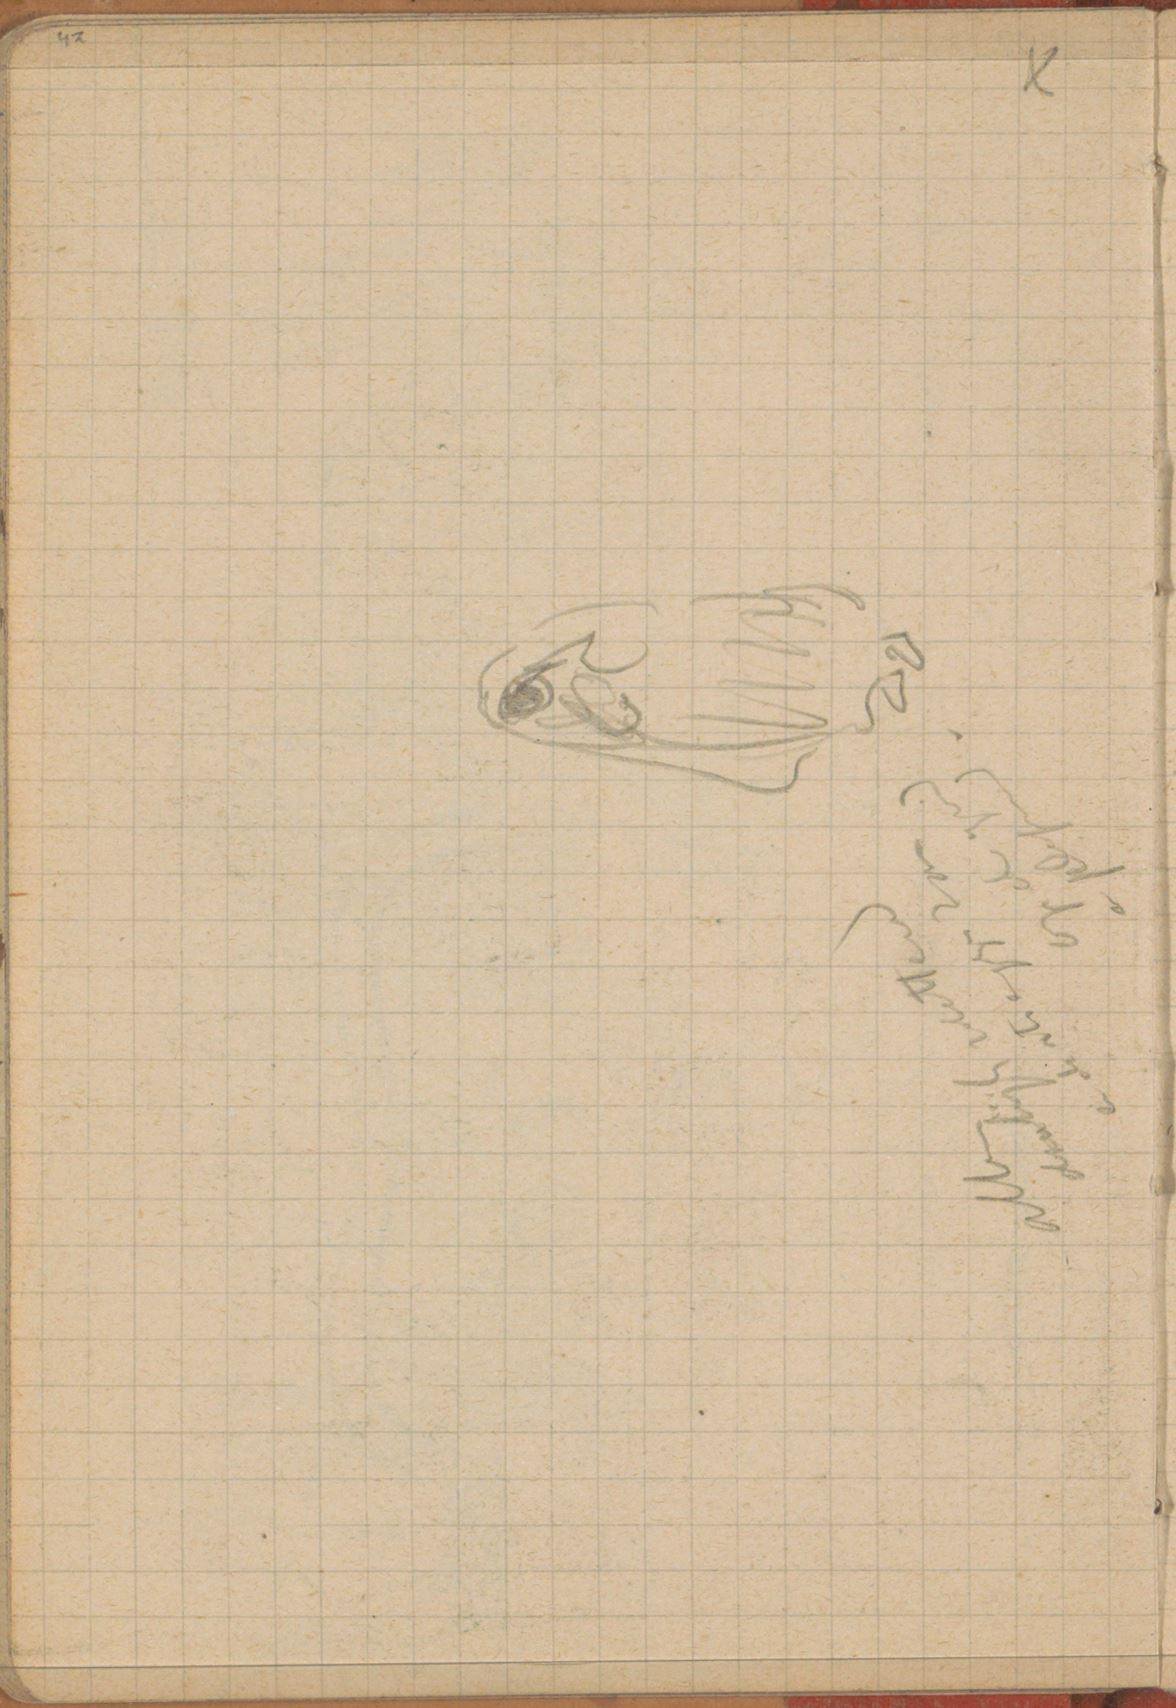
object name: sketchbook leaf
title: Gesluierde figuur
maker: marius bauer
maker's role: draughtsman, print maker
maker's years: 1867-1932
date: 1909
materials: pencil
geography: tunis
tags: standing figure, folk costume, regional costume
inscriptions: kleurnotitie, handgeschreven: verwijst naar de schets op pagina 43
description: Pagina 42 uit een schetsboek met 67 bladen.